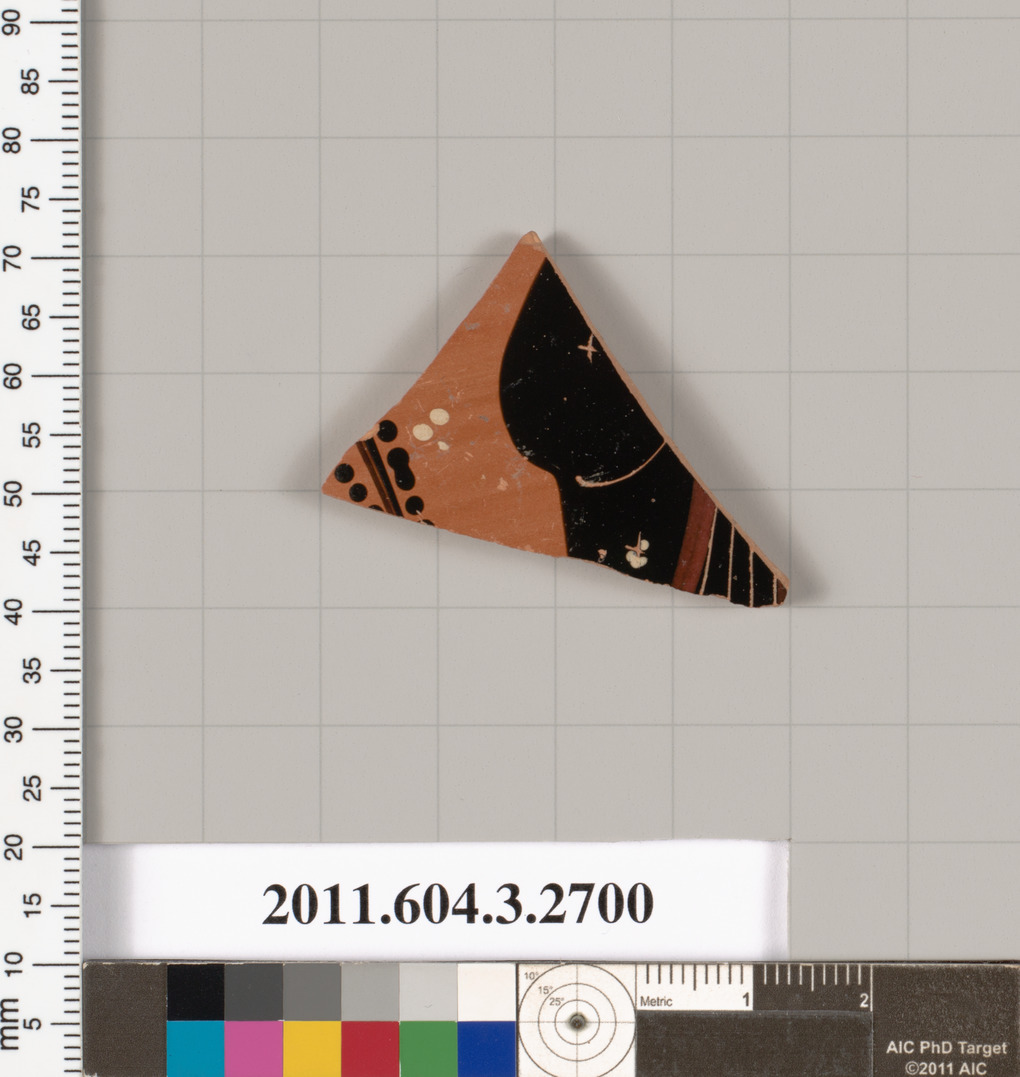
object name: oinochoe fragment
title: Terracotta fragment of an oinochoe (jug)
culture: greek, attic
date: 510-500 BCE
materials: terracotta